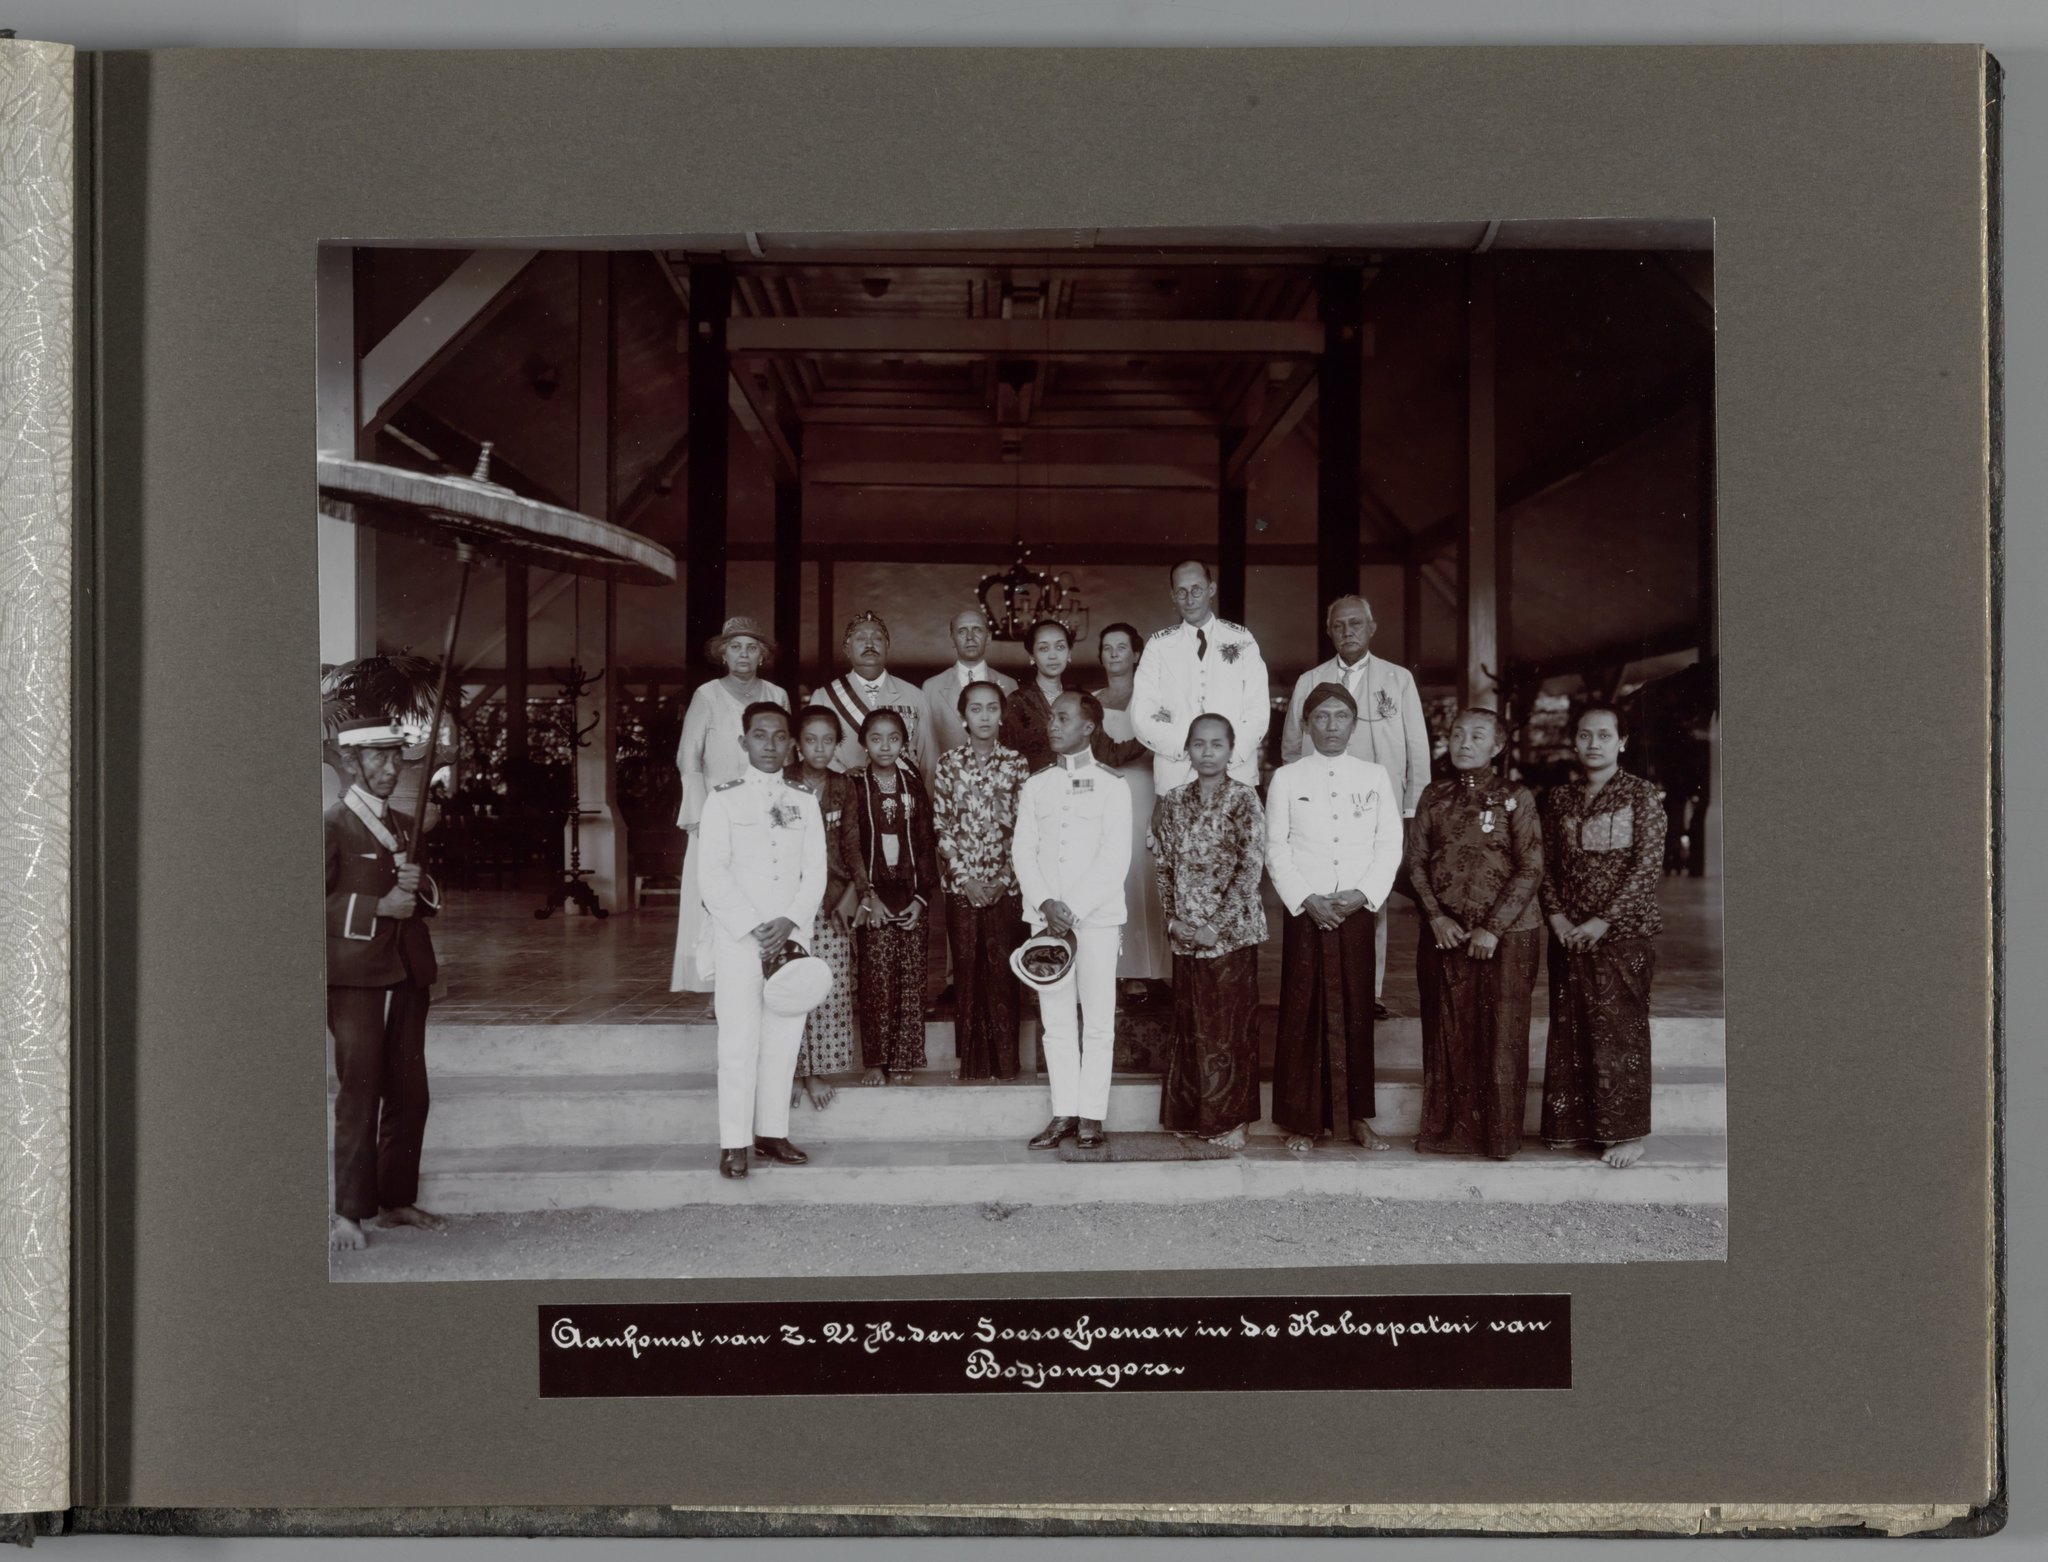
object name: photograph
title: Aankomst van Z.V.H. den Soesoehoenan in de Kaboepaten van Bodjonagoro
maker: Anonymous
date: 1933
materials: photographic support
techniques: photography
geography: cepu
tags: historical persons, royal household; courtiers, retinue, train, colonial government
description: Groepsfoto van de Soesoehoenan met zijn gevolg en enkele Nederlanders in de Kaboepaten (woning van de regent) van Bodjonagoro. Foto in het fotoalbum met 14 foto's ter herinnering aan het bezoek van de Soesoehoenan Pakoe Boewono X van Soerakarta Hadiningrat, aan Cepu (Tjepoe) en omgeving op 14 juni 1933.